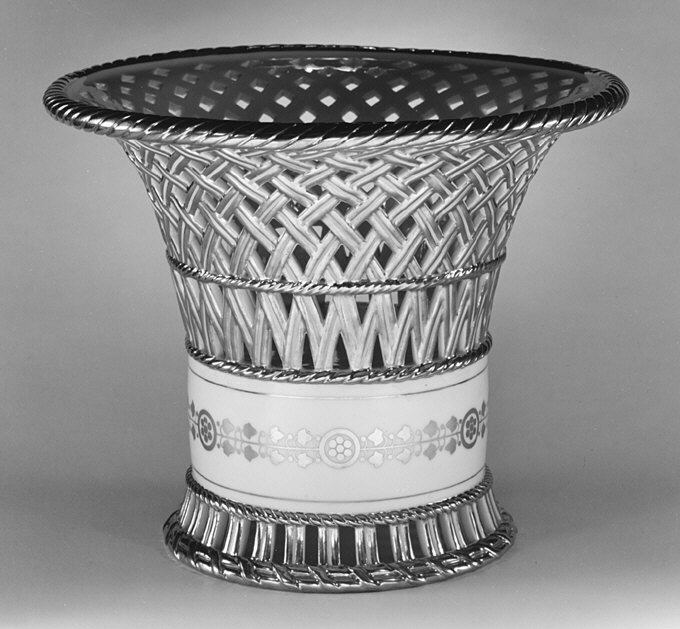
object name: fruit basket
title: Fruit basket (one of a pair)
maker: sèvres manufactory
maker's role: manufactory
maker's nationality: french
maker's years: 1740-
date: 1830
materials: hard paste porcelain